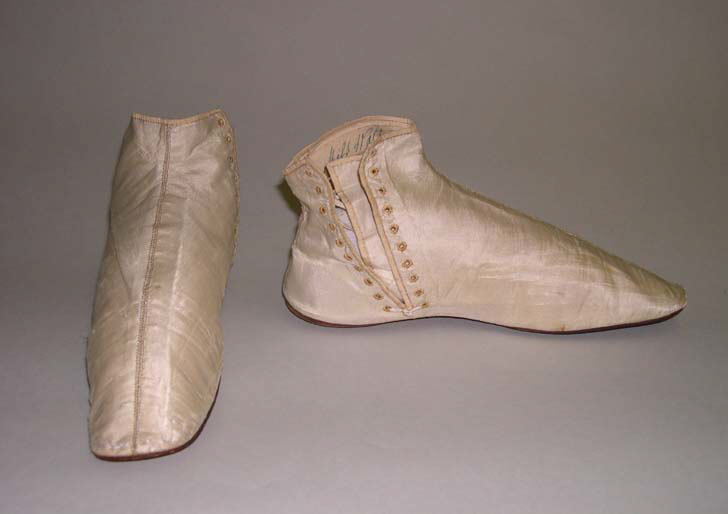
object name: boot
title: Boots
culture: american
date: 1830-1839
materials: leather, silk